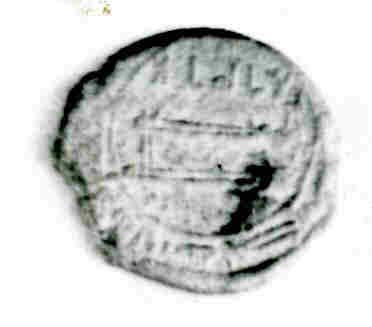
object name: coin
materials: copper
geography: iran